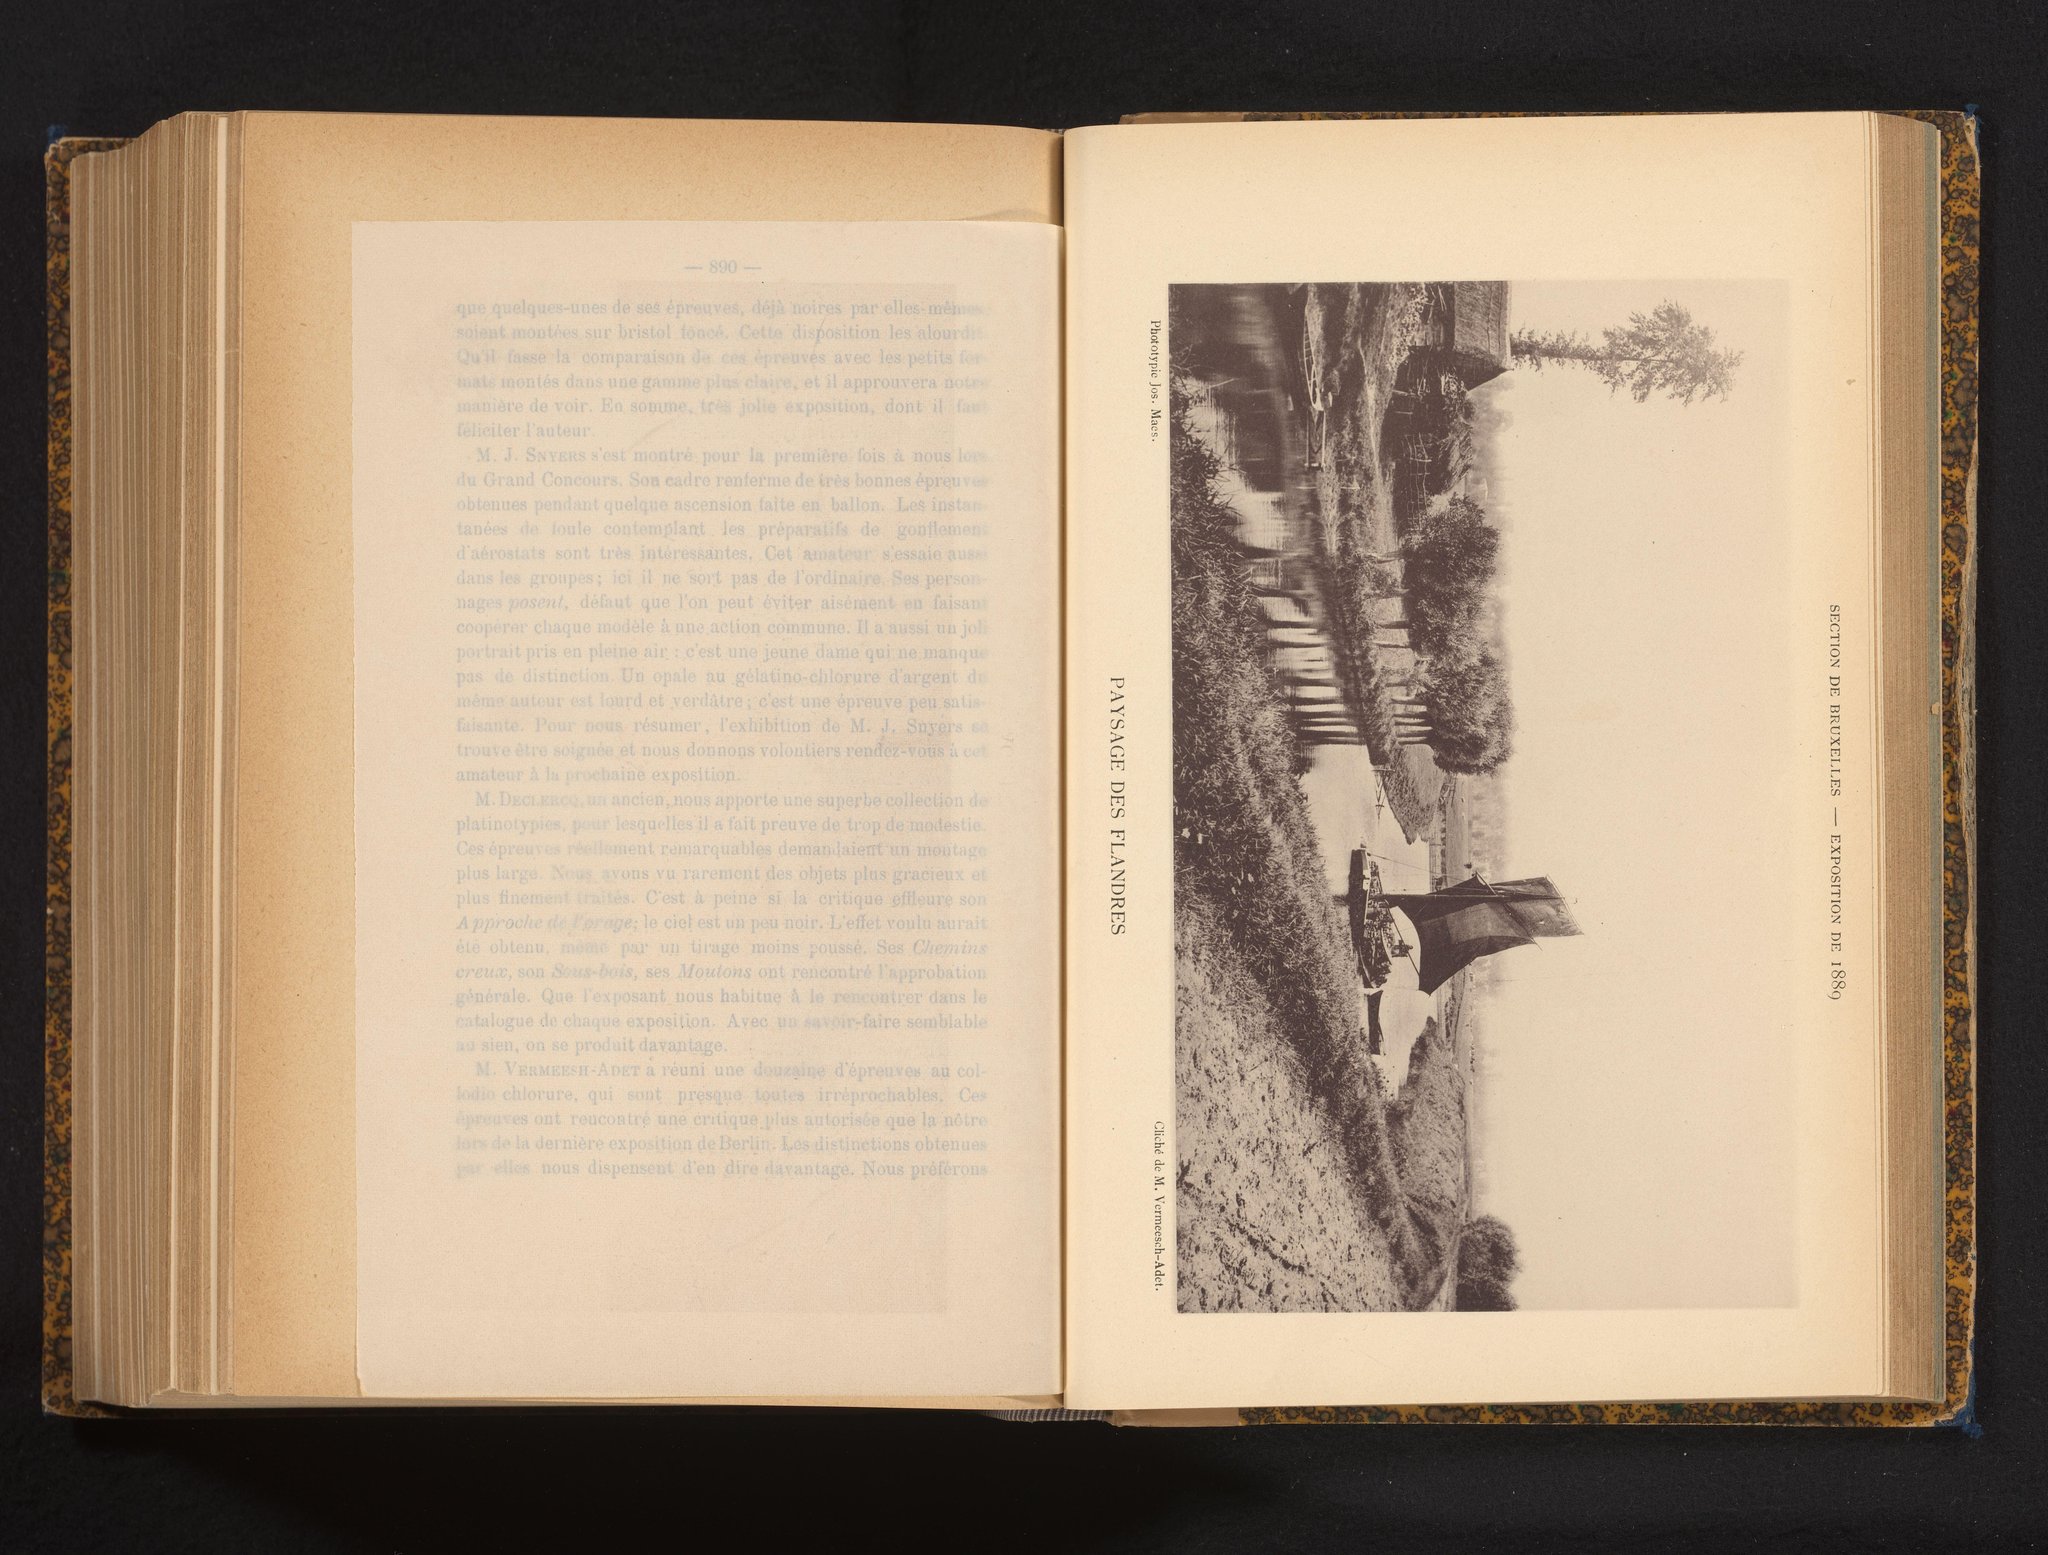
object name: photomechanical print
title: Paysage des Flandres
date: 1883-1888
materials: paper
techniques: photograph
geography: antwerp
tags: sailing-ship, sailing-boat, river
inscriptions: inscription: ‘Section de Bruxelles - Exposition de 1889’